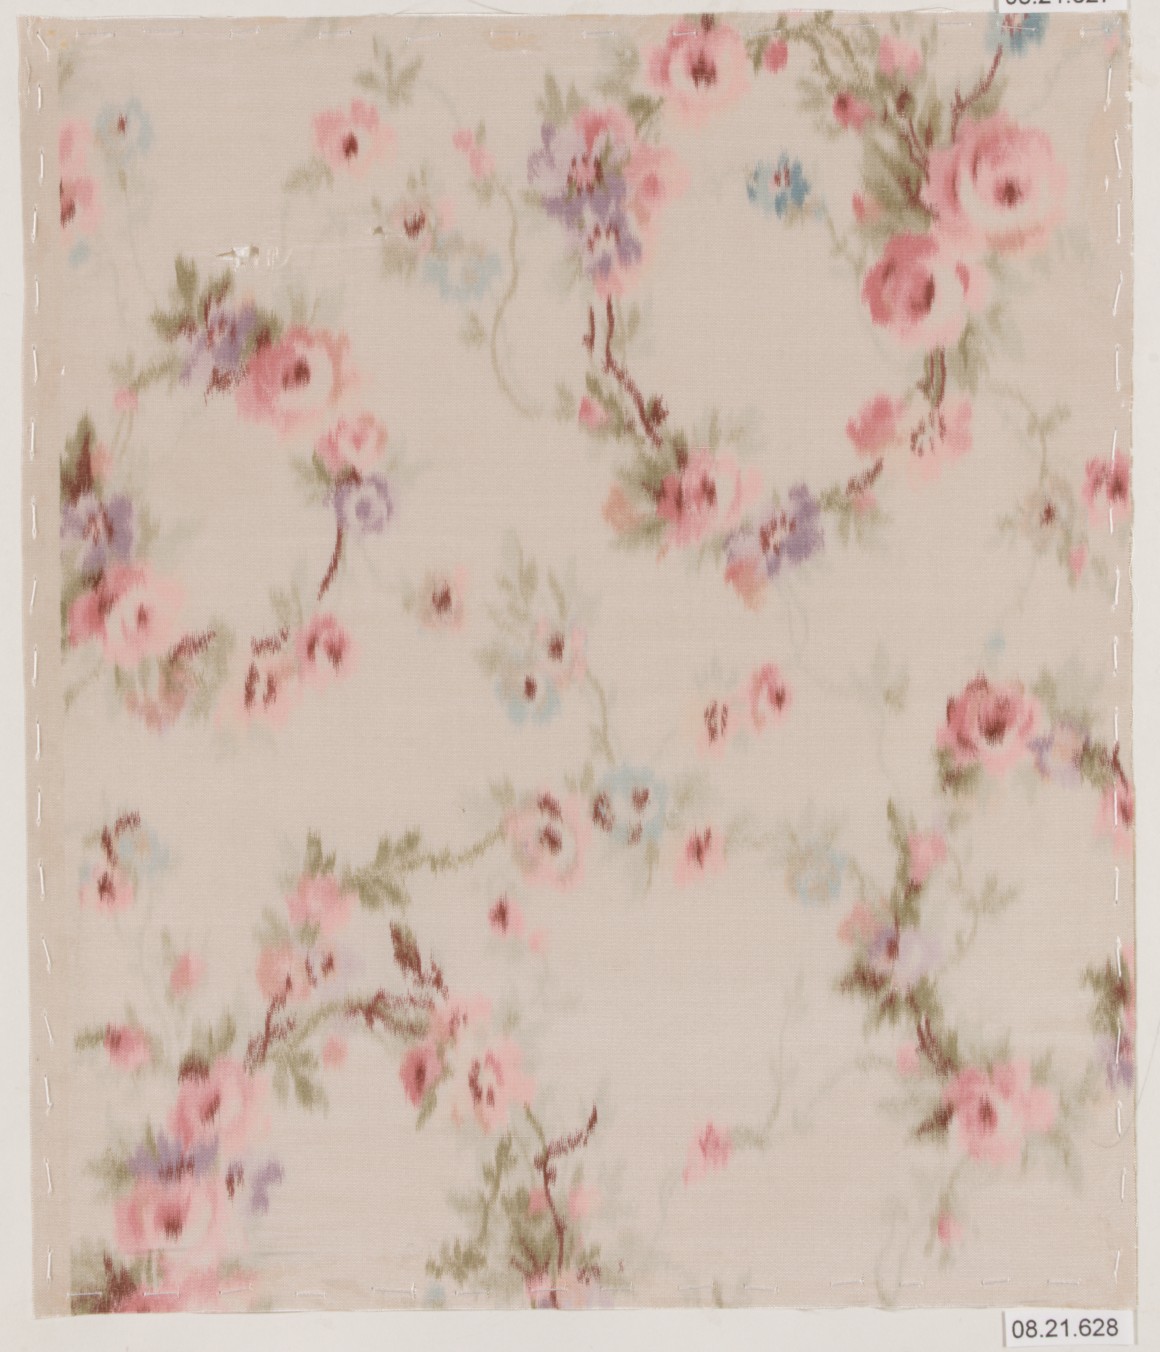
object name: textile sample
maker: Anonymous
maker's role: designer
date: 1900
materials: silk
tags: flowers